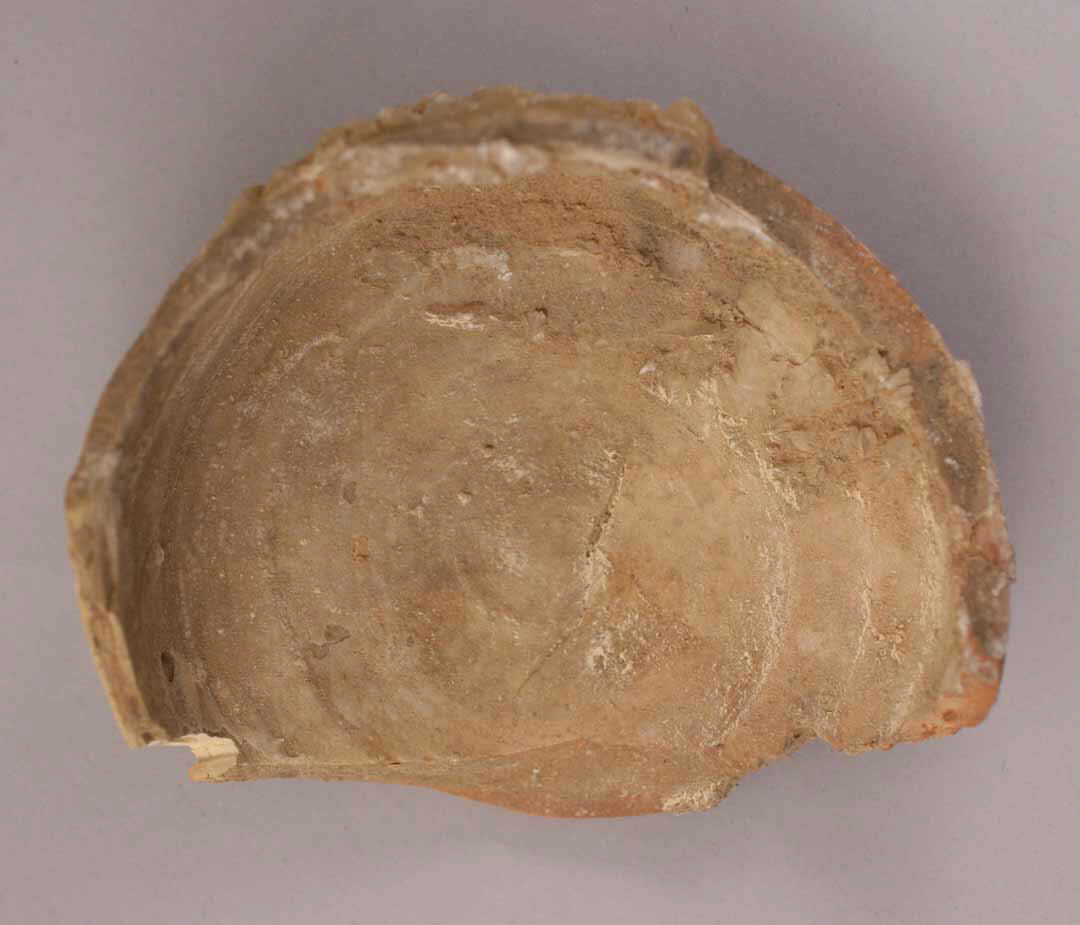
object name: fragment of a bowl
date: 801-900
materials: earthenware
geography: iraq